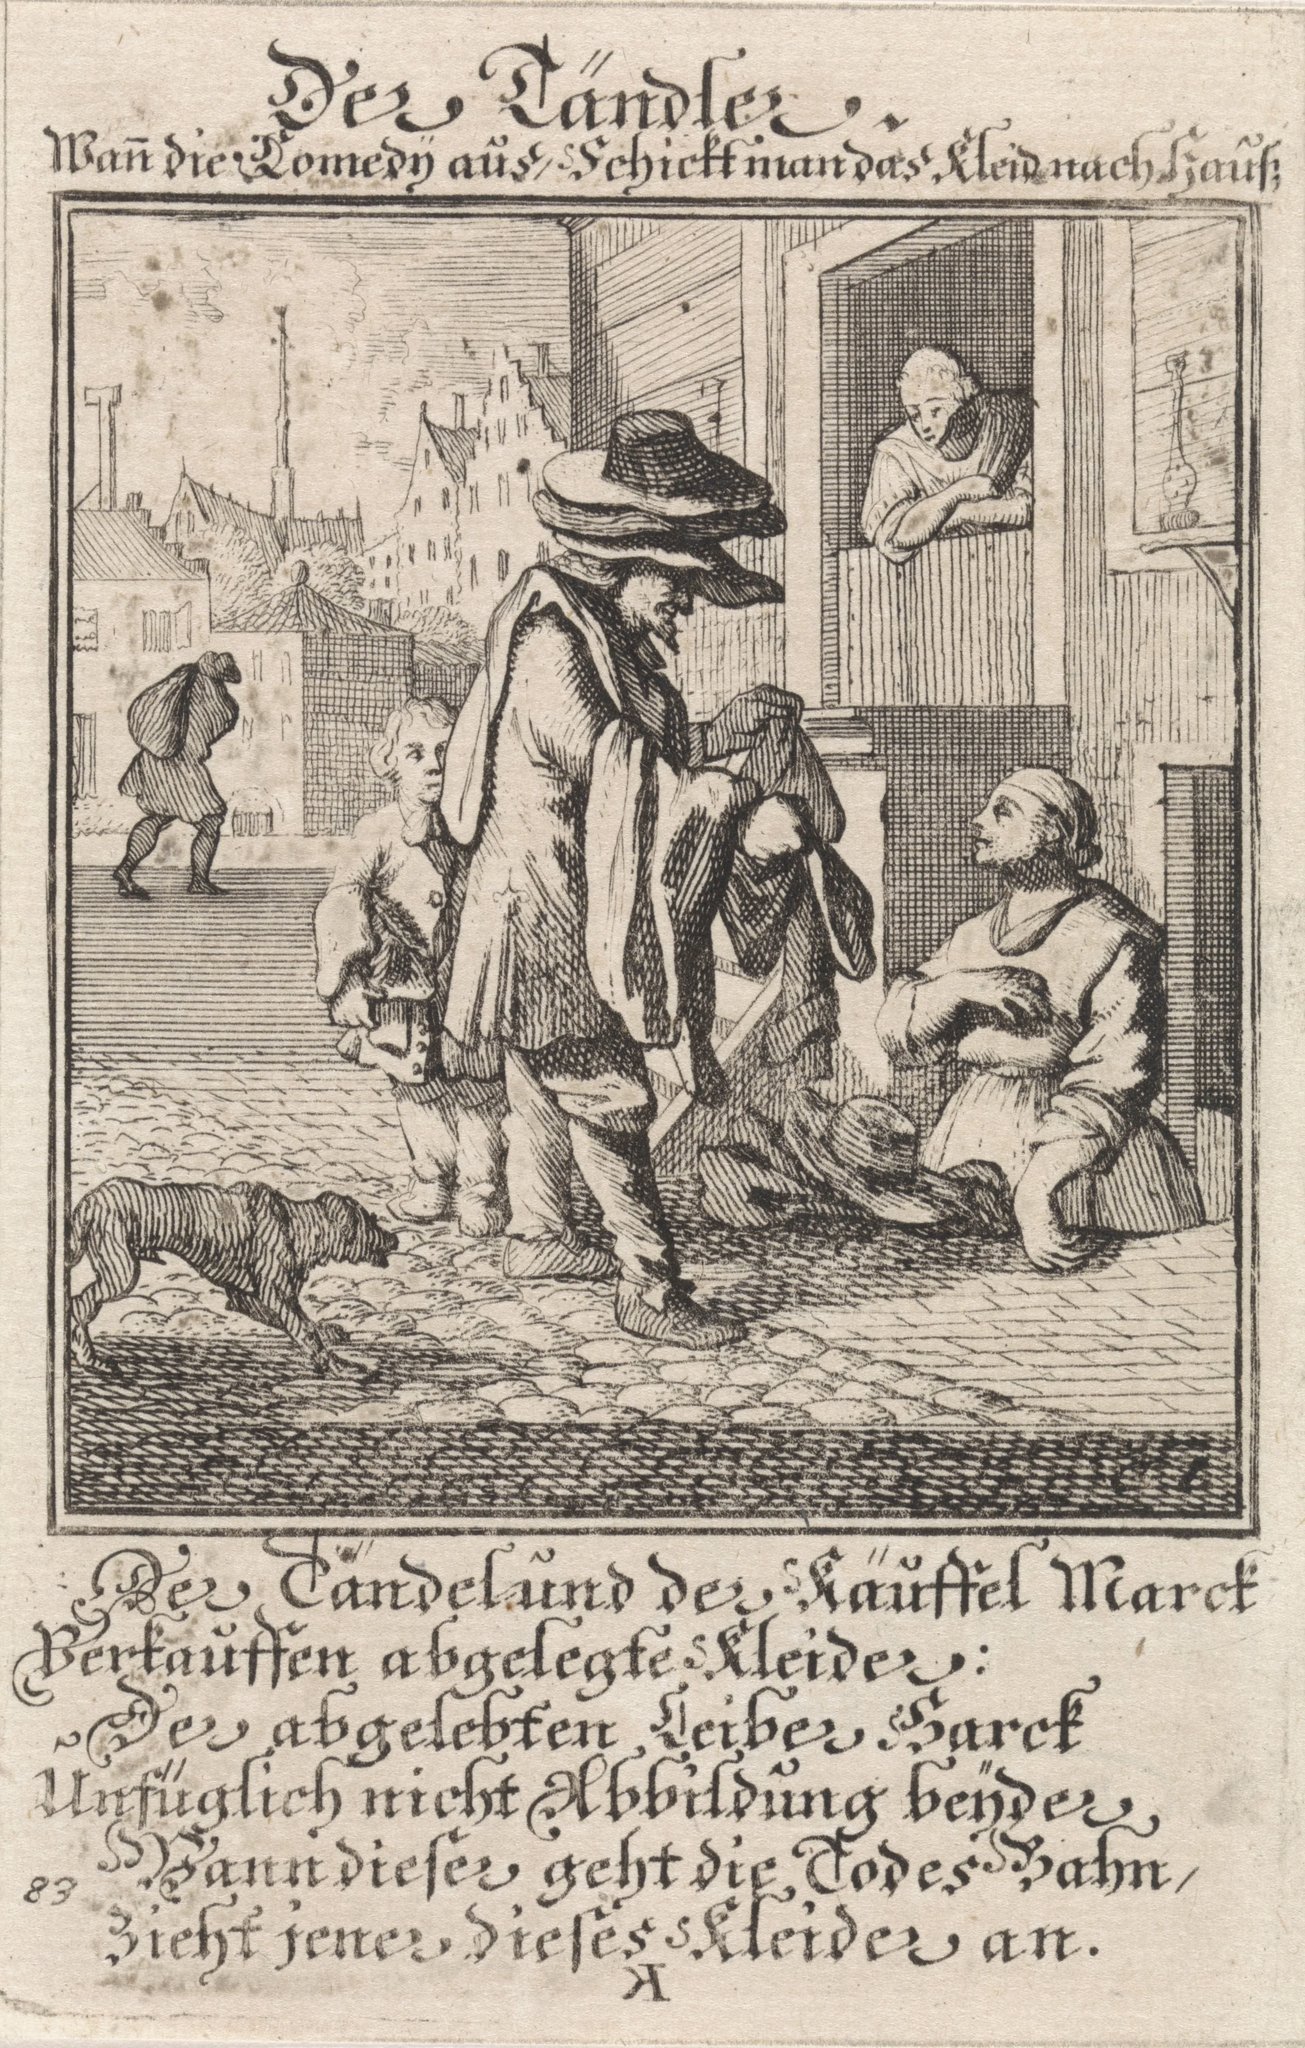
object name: print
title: Der Tändler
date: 1711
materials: paper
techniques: etching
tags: pedlar, head-gear: hat (+ men's clothes), clothes, costume (+ men's clothes)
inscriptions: collector's mark: Lugt 2228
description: Illustratie uit: Sancta Clara, Abraham à. Etwas für Alle, das ist: Eine kurtze Beschreibung allerley Stands- Ambts- und Gewerbs-Persohnen (...), 3 delen (1699-1733). Würtzburg: Martin Frantz Hertz, 1711, dl. III, p. 771. Het betreft hier de tweede druk van deel III.